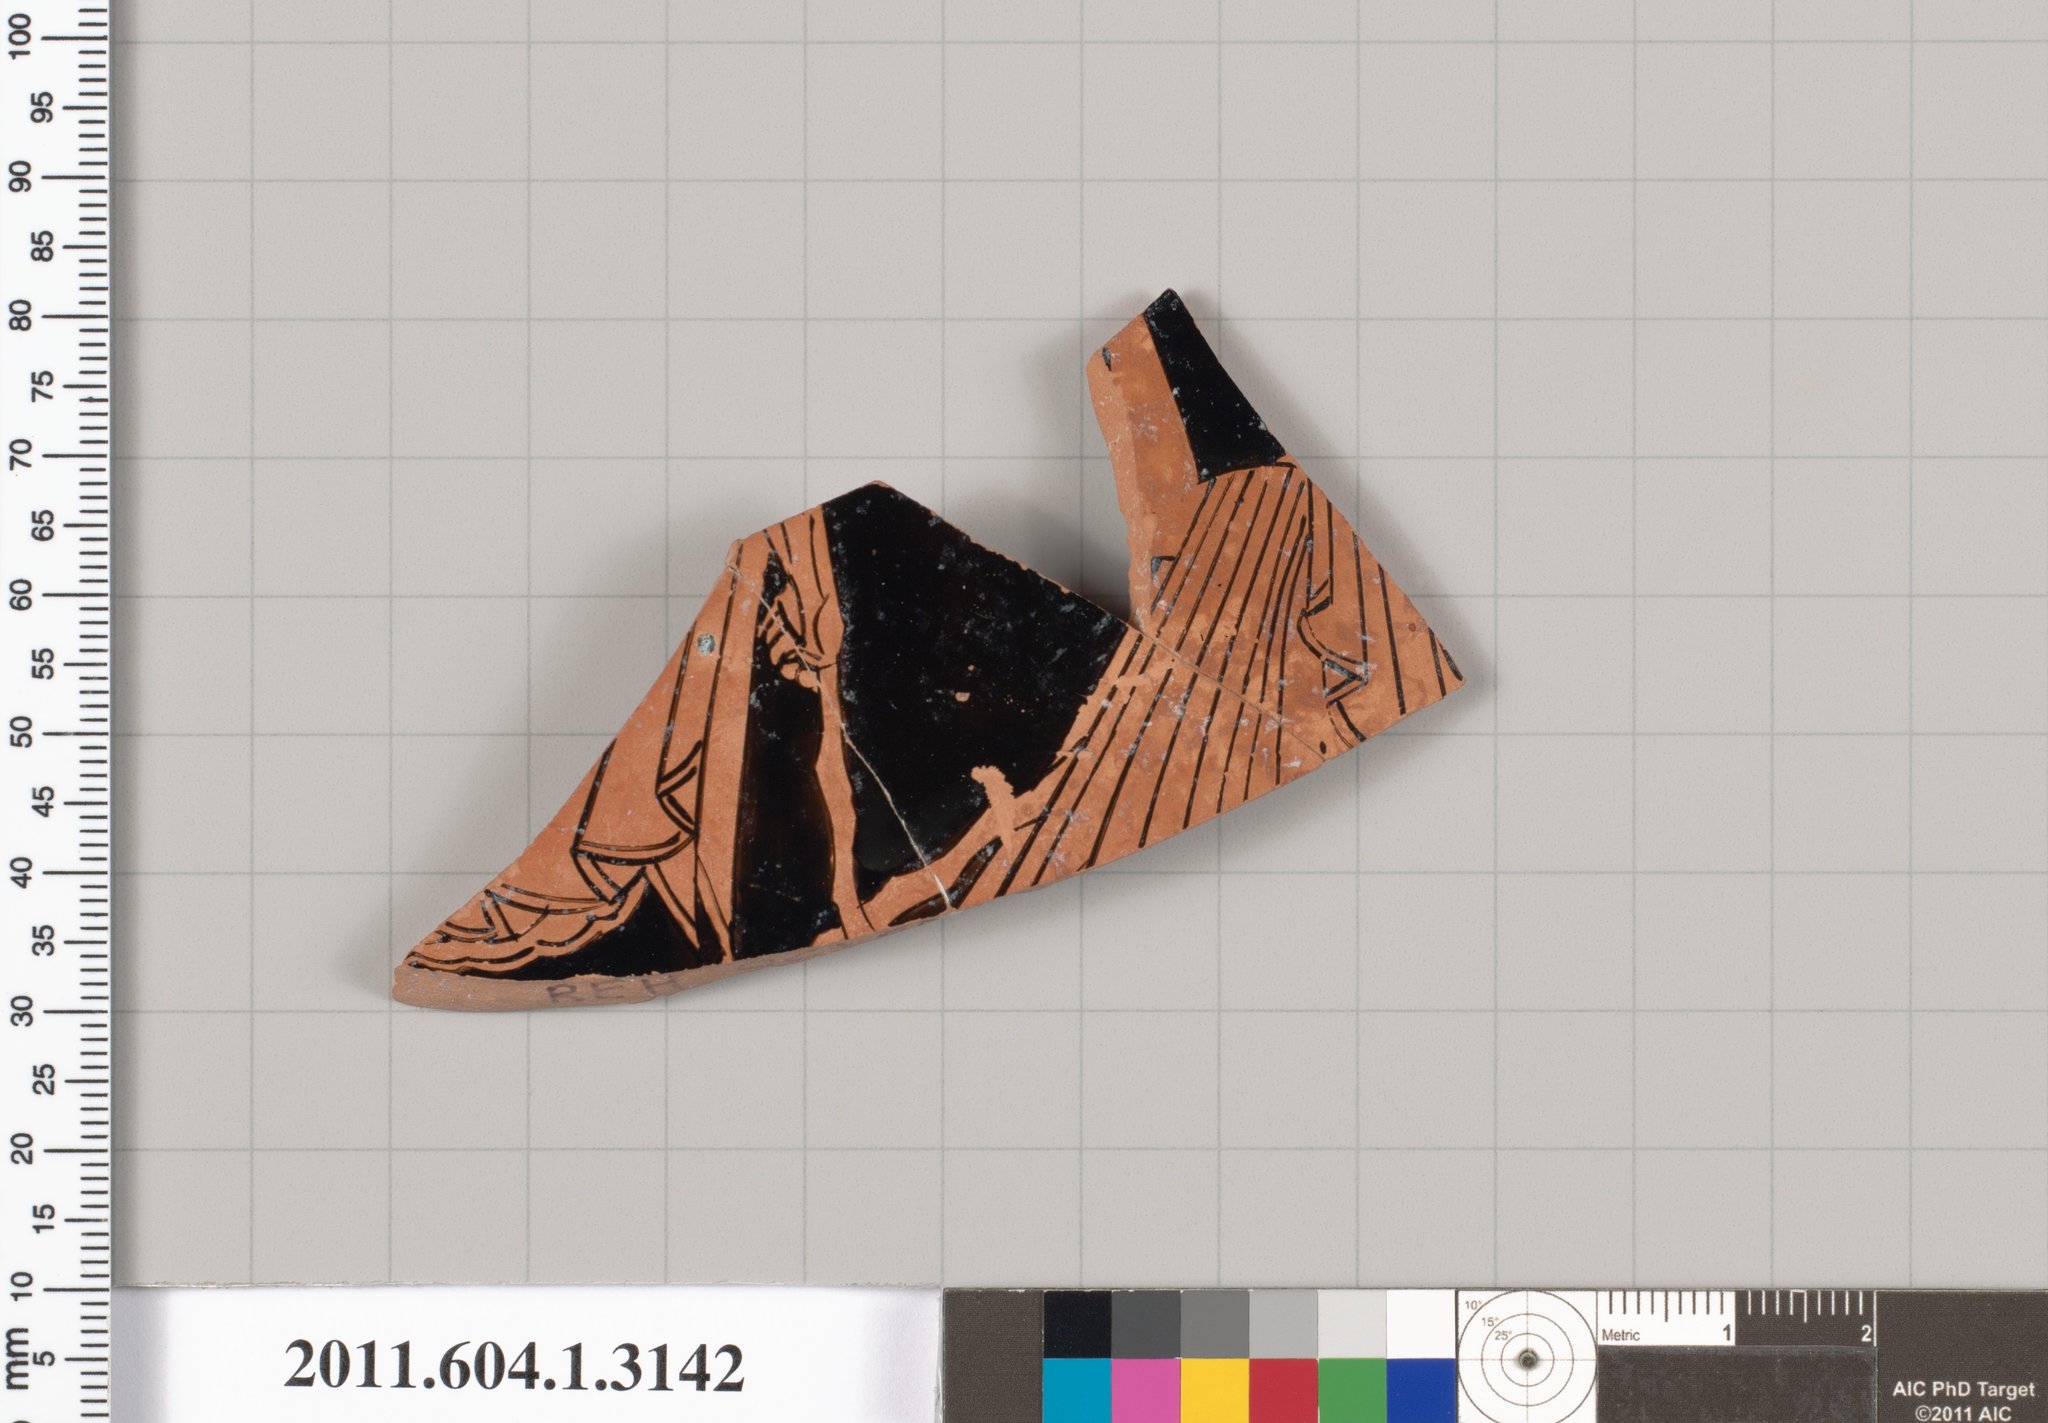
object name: kylix fragment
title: Terracotta fragment of a kylix (drinking cup)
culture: greek, attic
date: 510-490 BCE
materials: terracotta